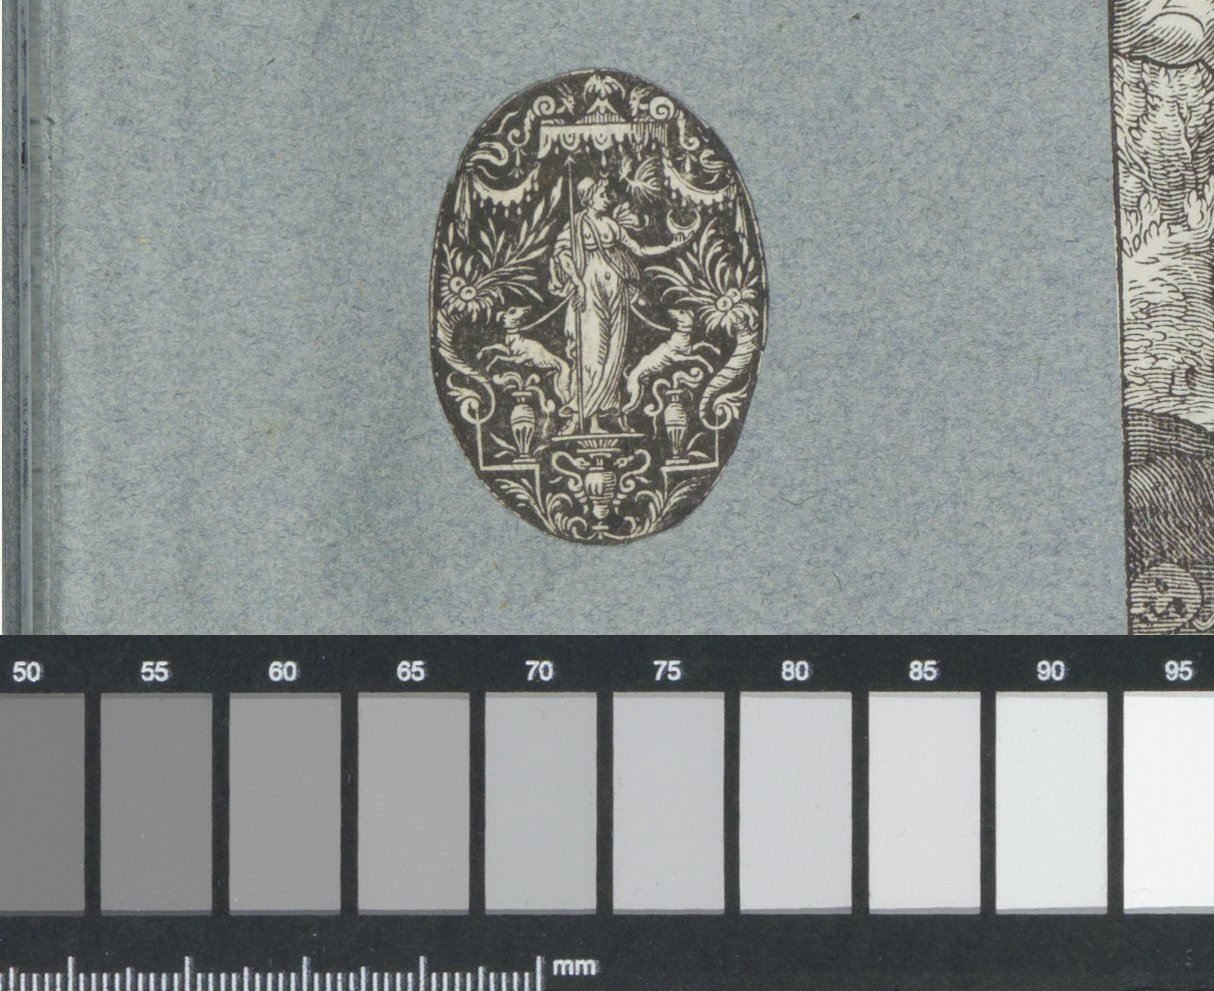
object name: book illustration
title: Diana met de maan in haar hand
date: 1628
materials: paper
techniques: woodcut, pasting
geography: amsterdam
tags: 'cornucopia', horn of plenty, ornamental decoration ~ printed matter, book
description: Ornament uit: Herman Hugo, Pia desideria emblematis, elegiis & affectibus S. S. Patrum illustrata, Antwerpen 1628. Volgens de titelpagina verscheen dit werk in Antwerpen bij Hendrick Aertssens, in werkelijkheid verscheen het in Amsterdam bij Pieter Jacobsz Paets (Dietz 2012, p. 58-59).